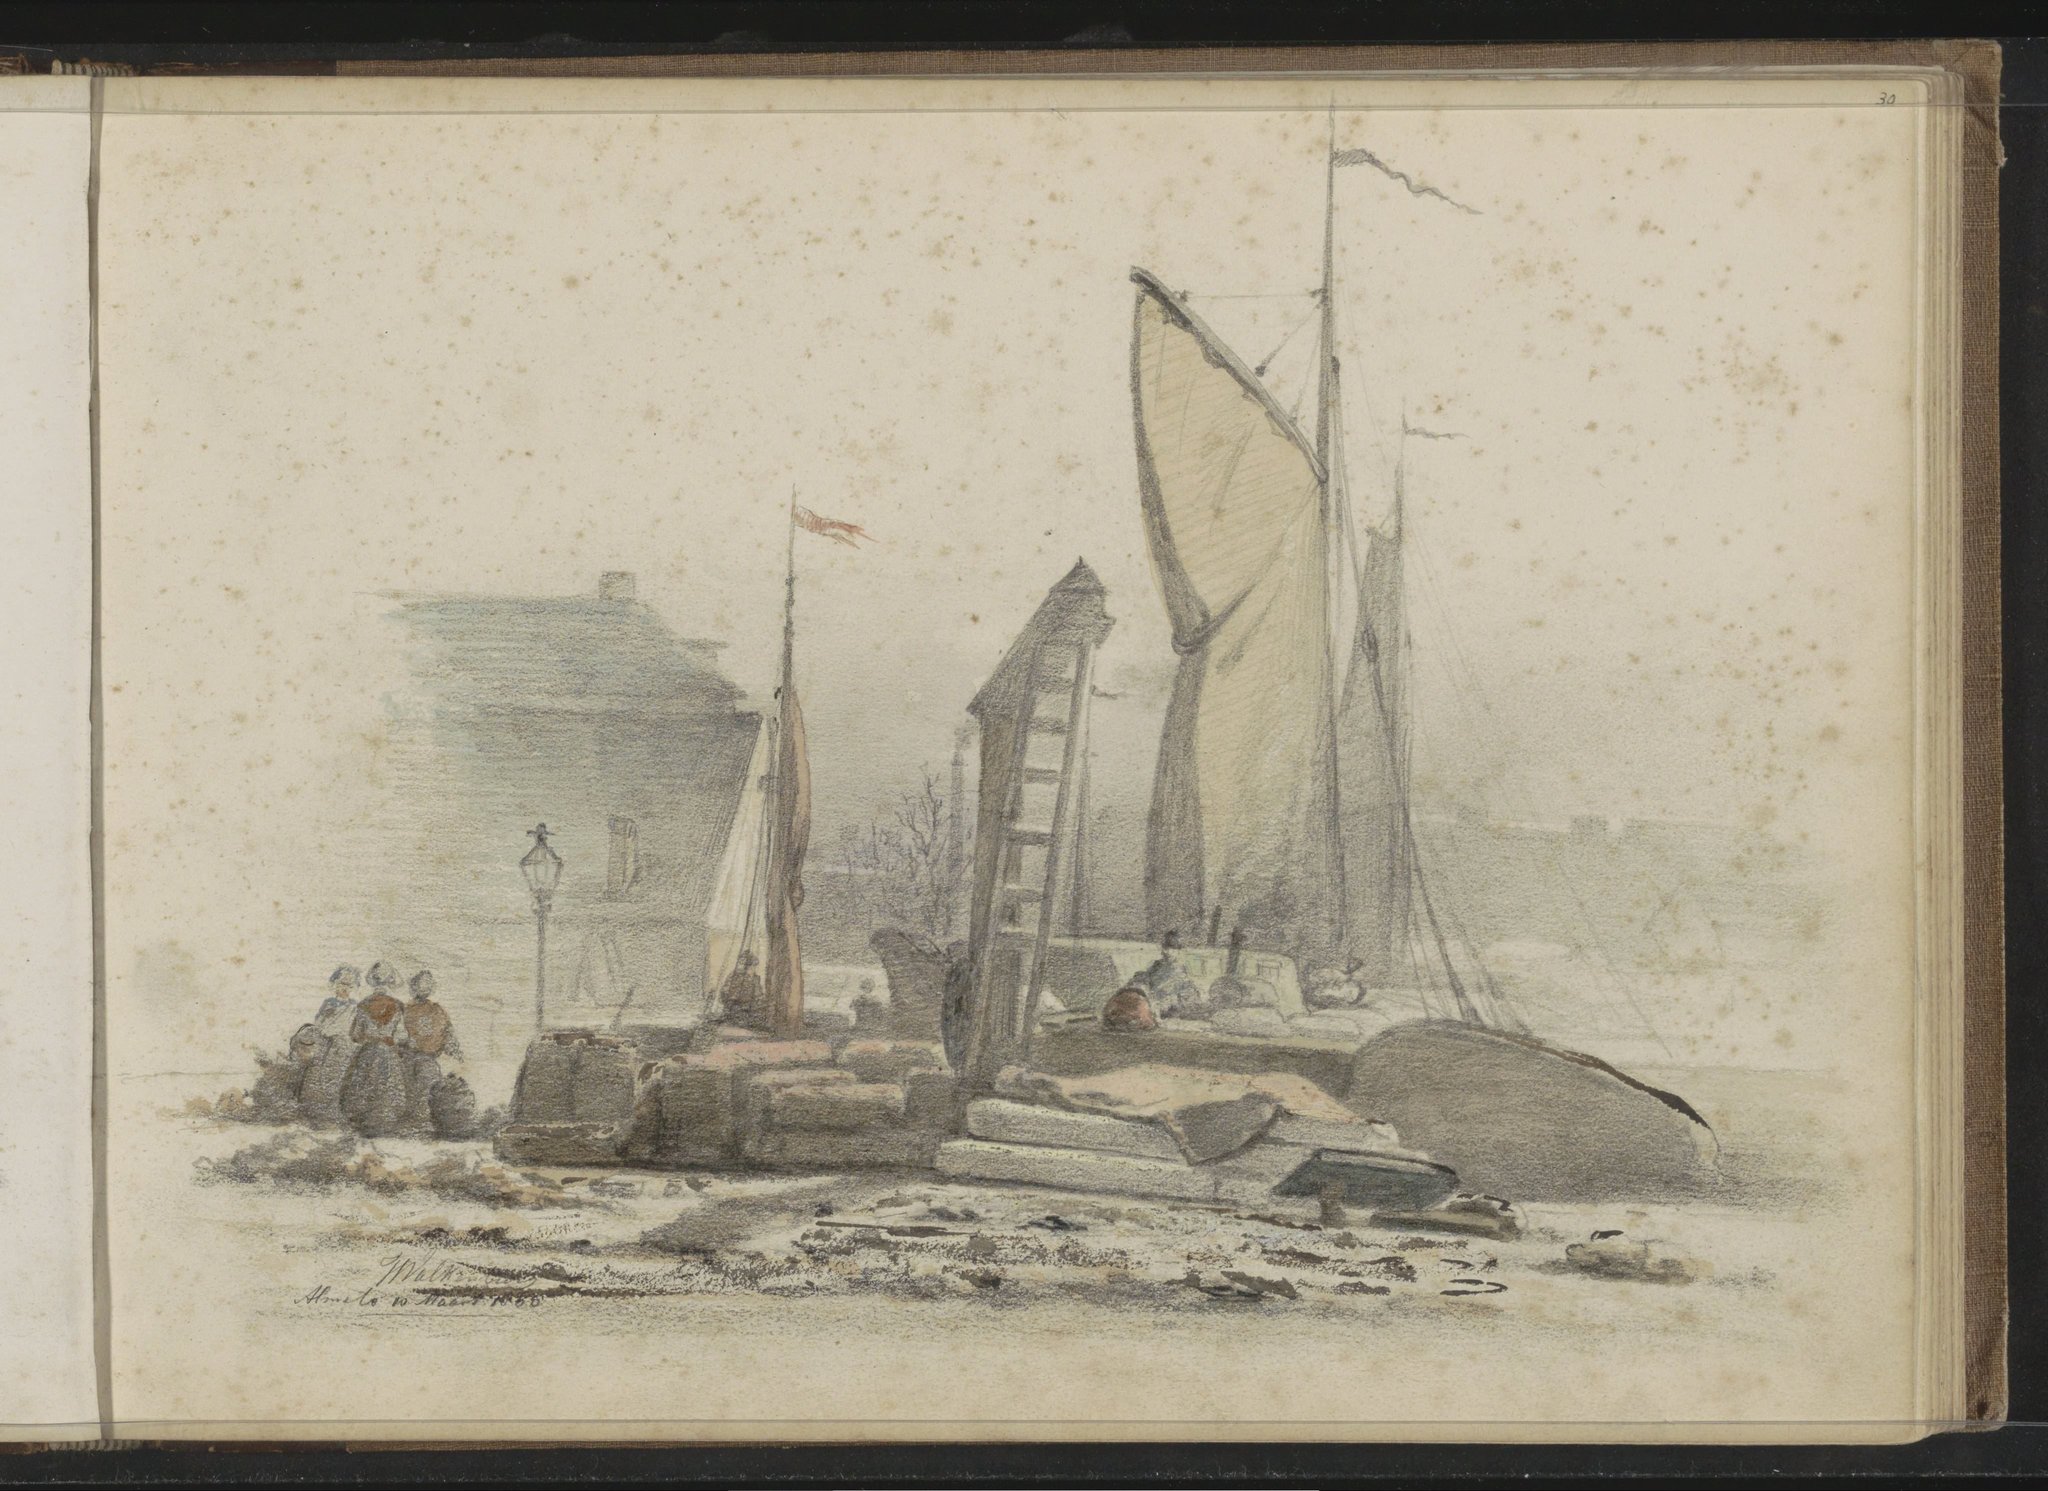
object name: sketchbook leaf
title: Haven van Almelo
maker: hendrik valkenburg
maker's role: draughtsman, painter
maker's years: 1826-1896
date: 1803-1860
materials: paper, pencil, watercolor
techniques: brush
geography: almelo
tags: sailing-ship, sailing-boat, pier, quay, wharf (+ view ~ vehicle, ship, etc.)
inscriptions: date and inscription: ‘Almelo 10 Maart 1860’, signature: ‘HValkenburg’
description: In de haven liggen zeilschepen aangemeerd. Op de kade liggen goederen en staat een groep vrouwen of meisjes in een kring. Blad 30 recto uit een schetsboek met 77 bladen.